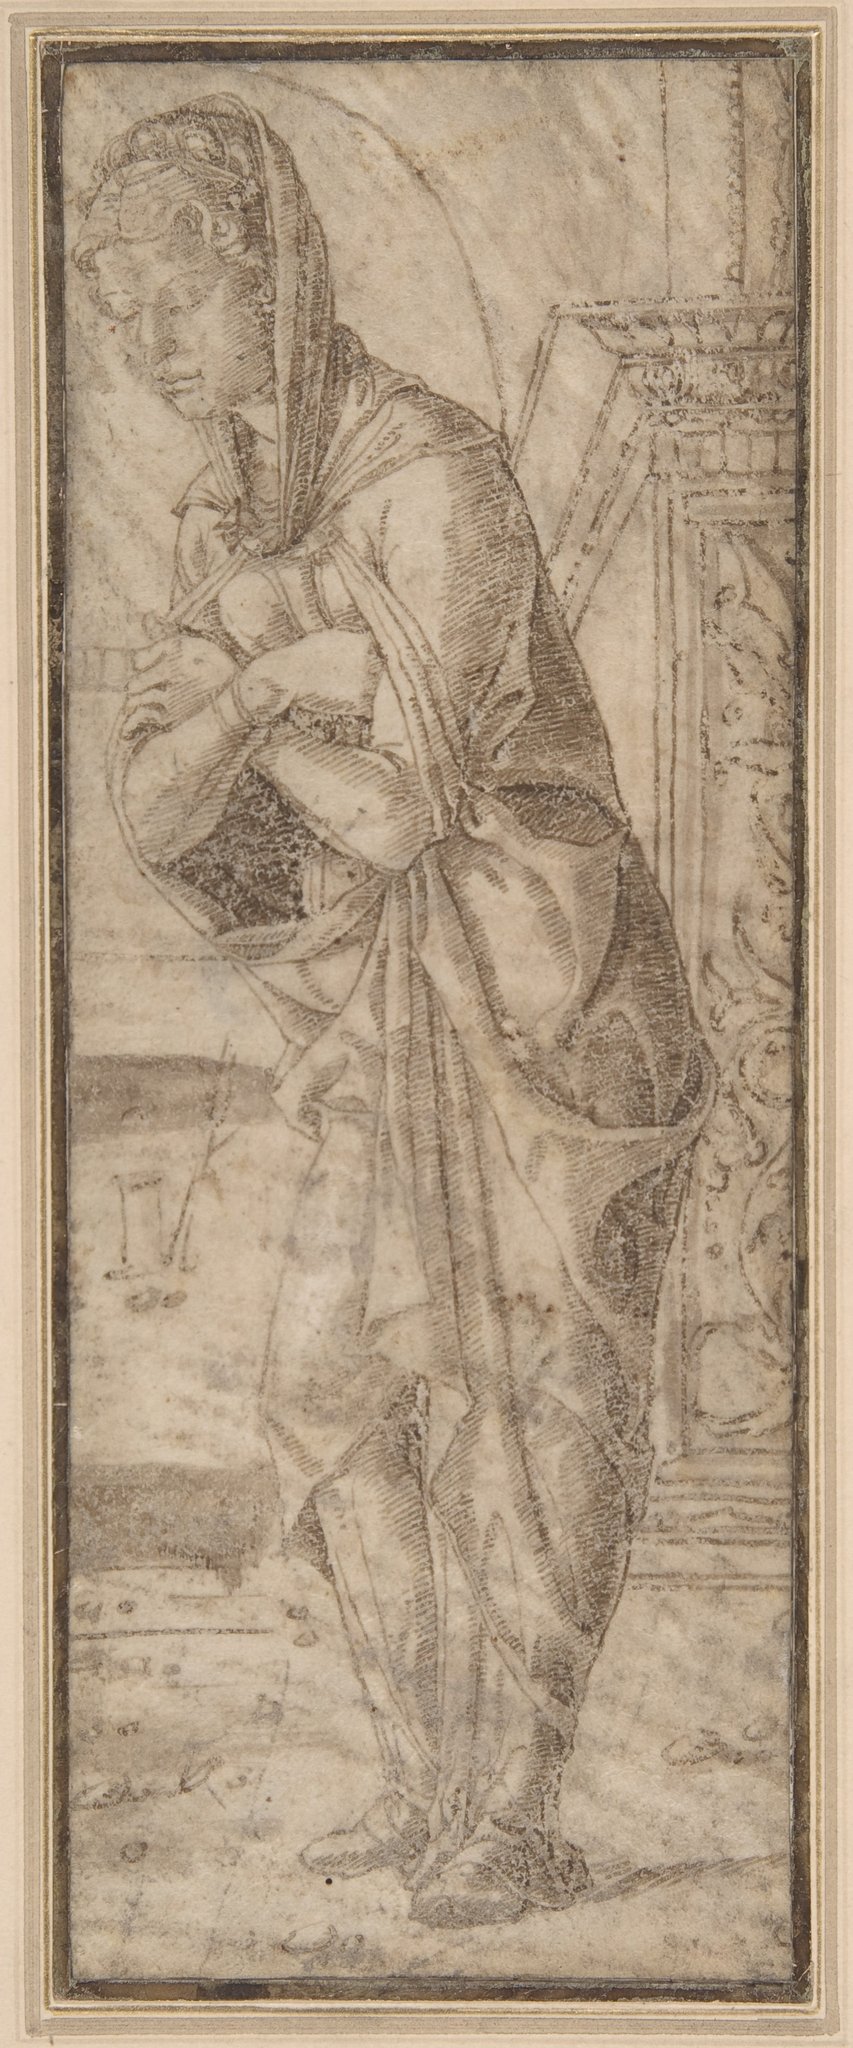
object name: drawing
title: The Virgin Annunciate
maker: anonymous, italian, ferrarese, 15th century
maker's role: artist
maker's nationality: italian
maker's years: 1400-1500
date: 1470-1480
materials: ink, parchment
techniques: brush, pen, wash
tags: virgin mary